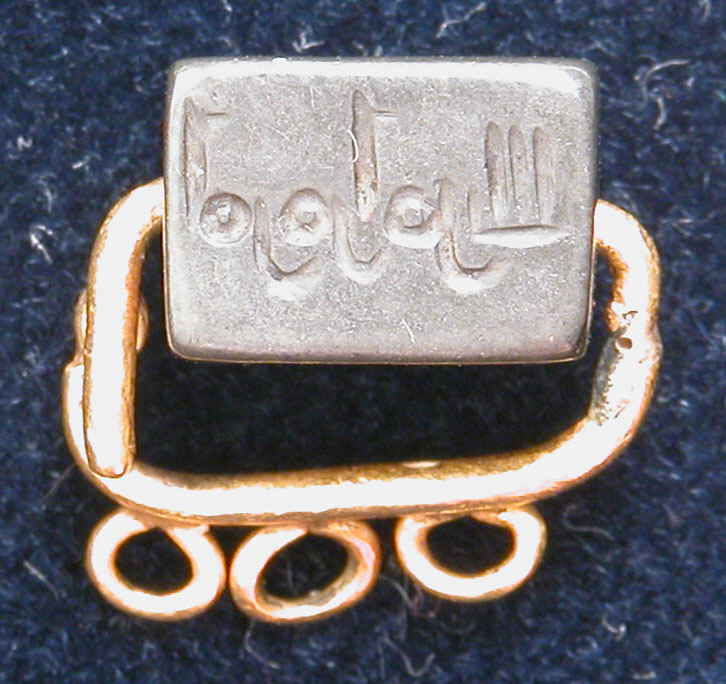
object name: seal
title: Seal Stone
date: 901-1100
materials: gold, mineral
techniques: incising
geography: iran